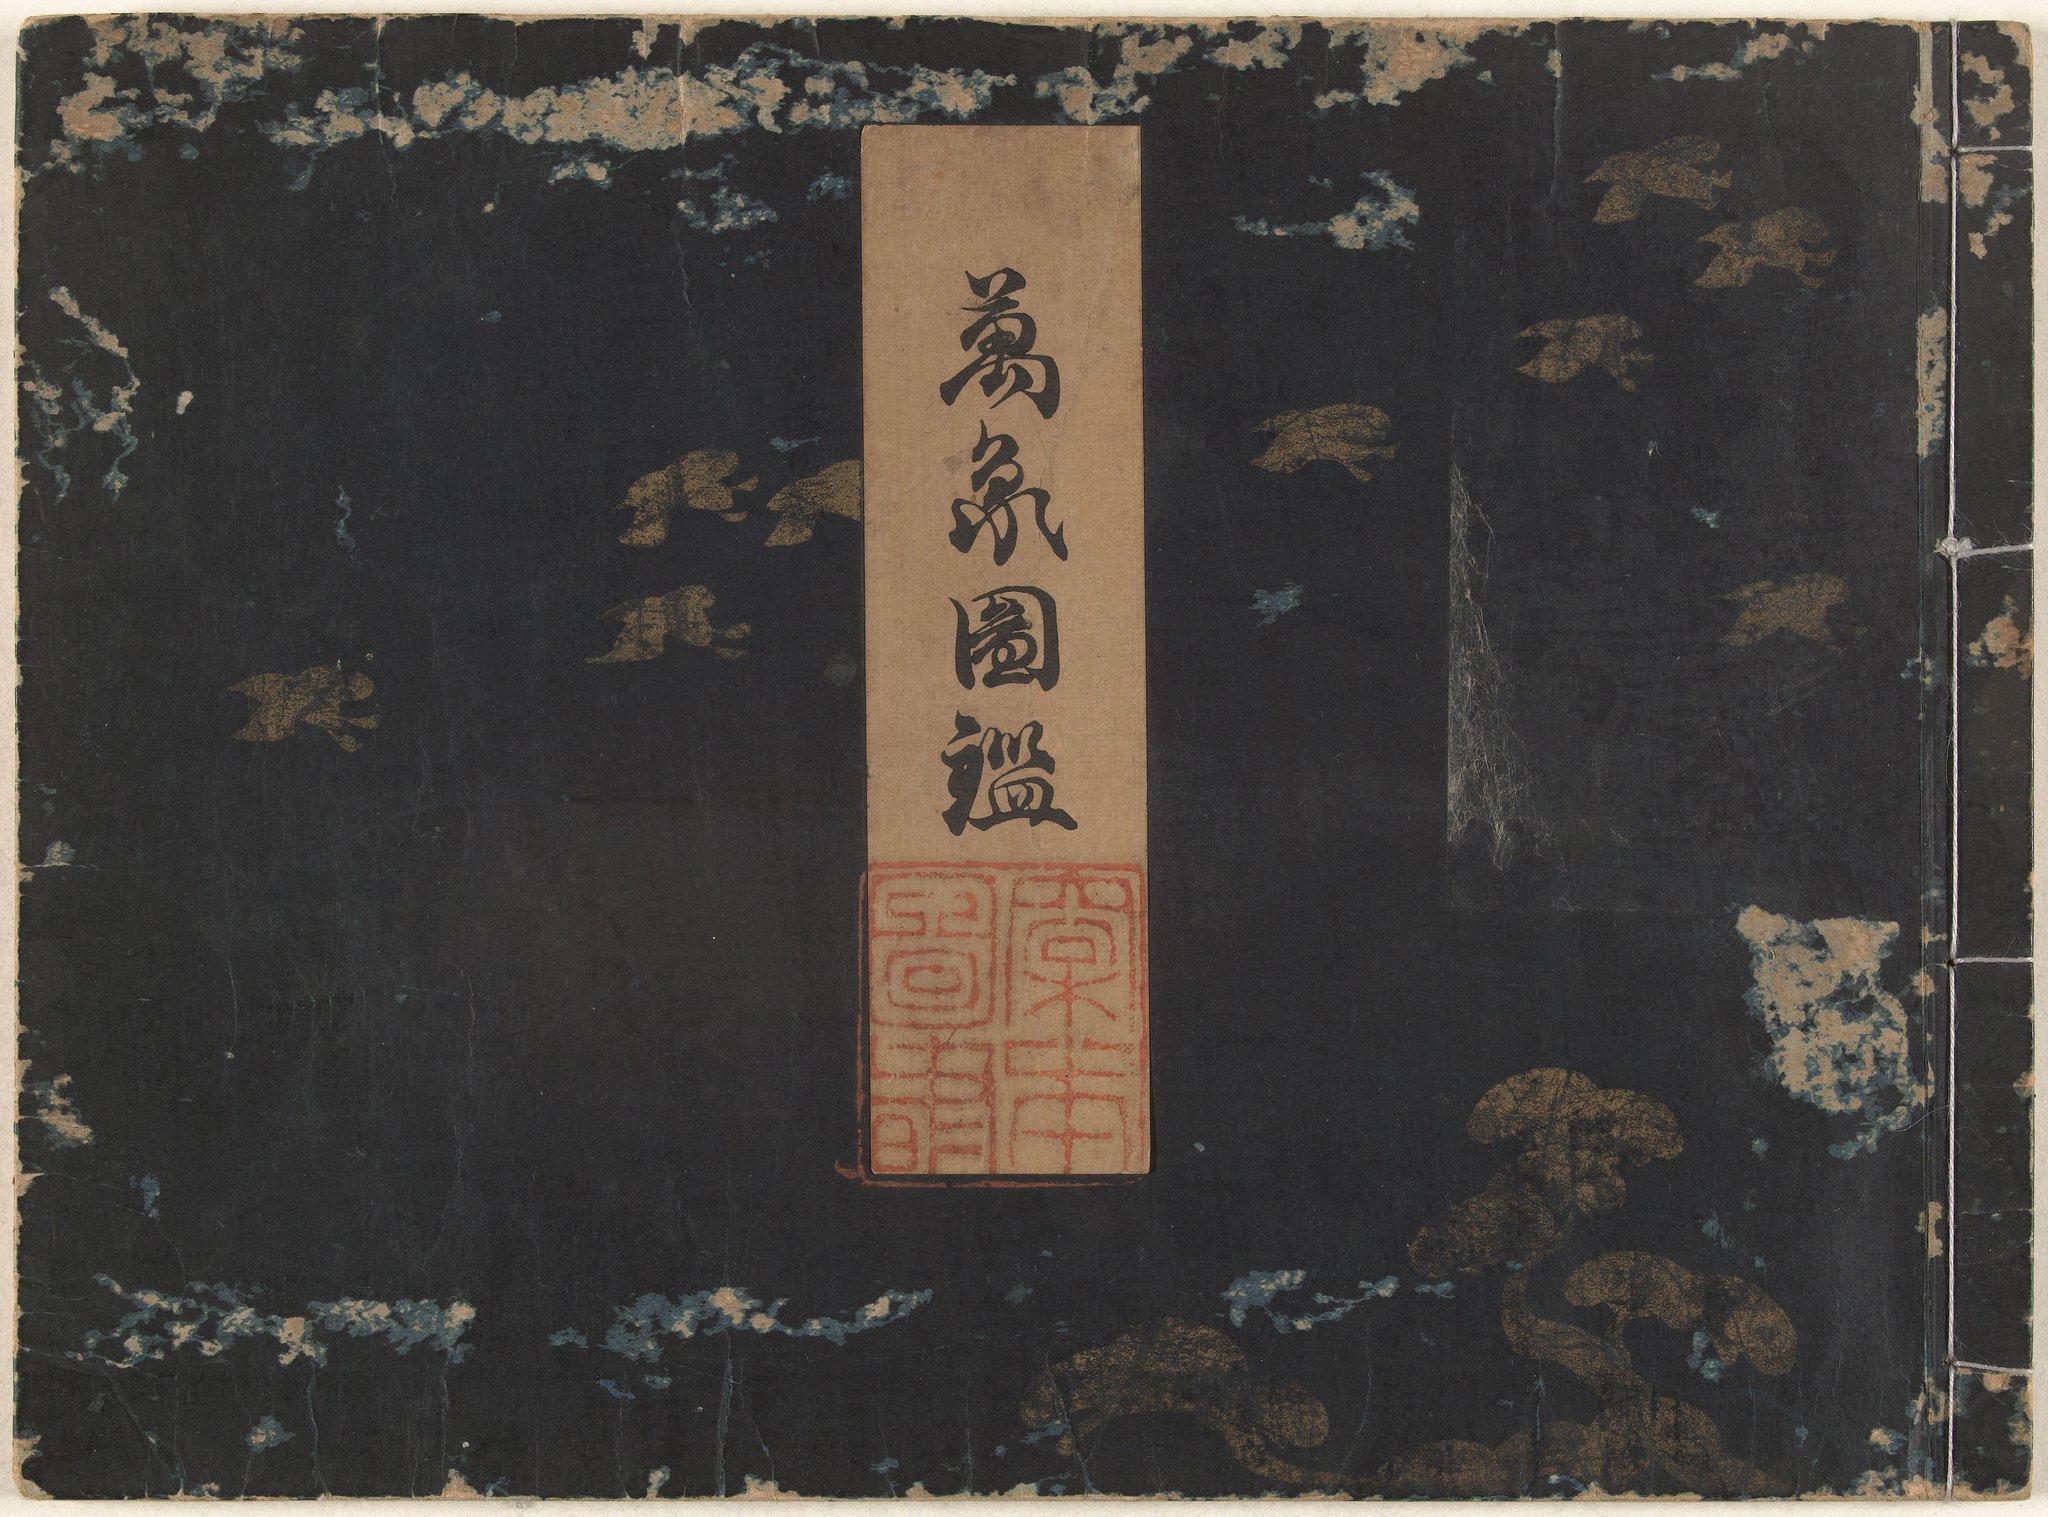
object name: book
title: Prentenboek der natuur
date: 1901-1904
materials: paper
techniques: woodcut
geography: japan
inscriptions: date